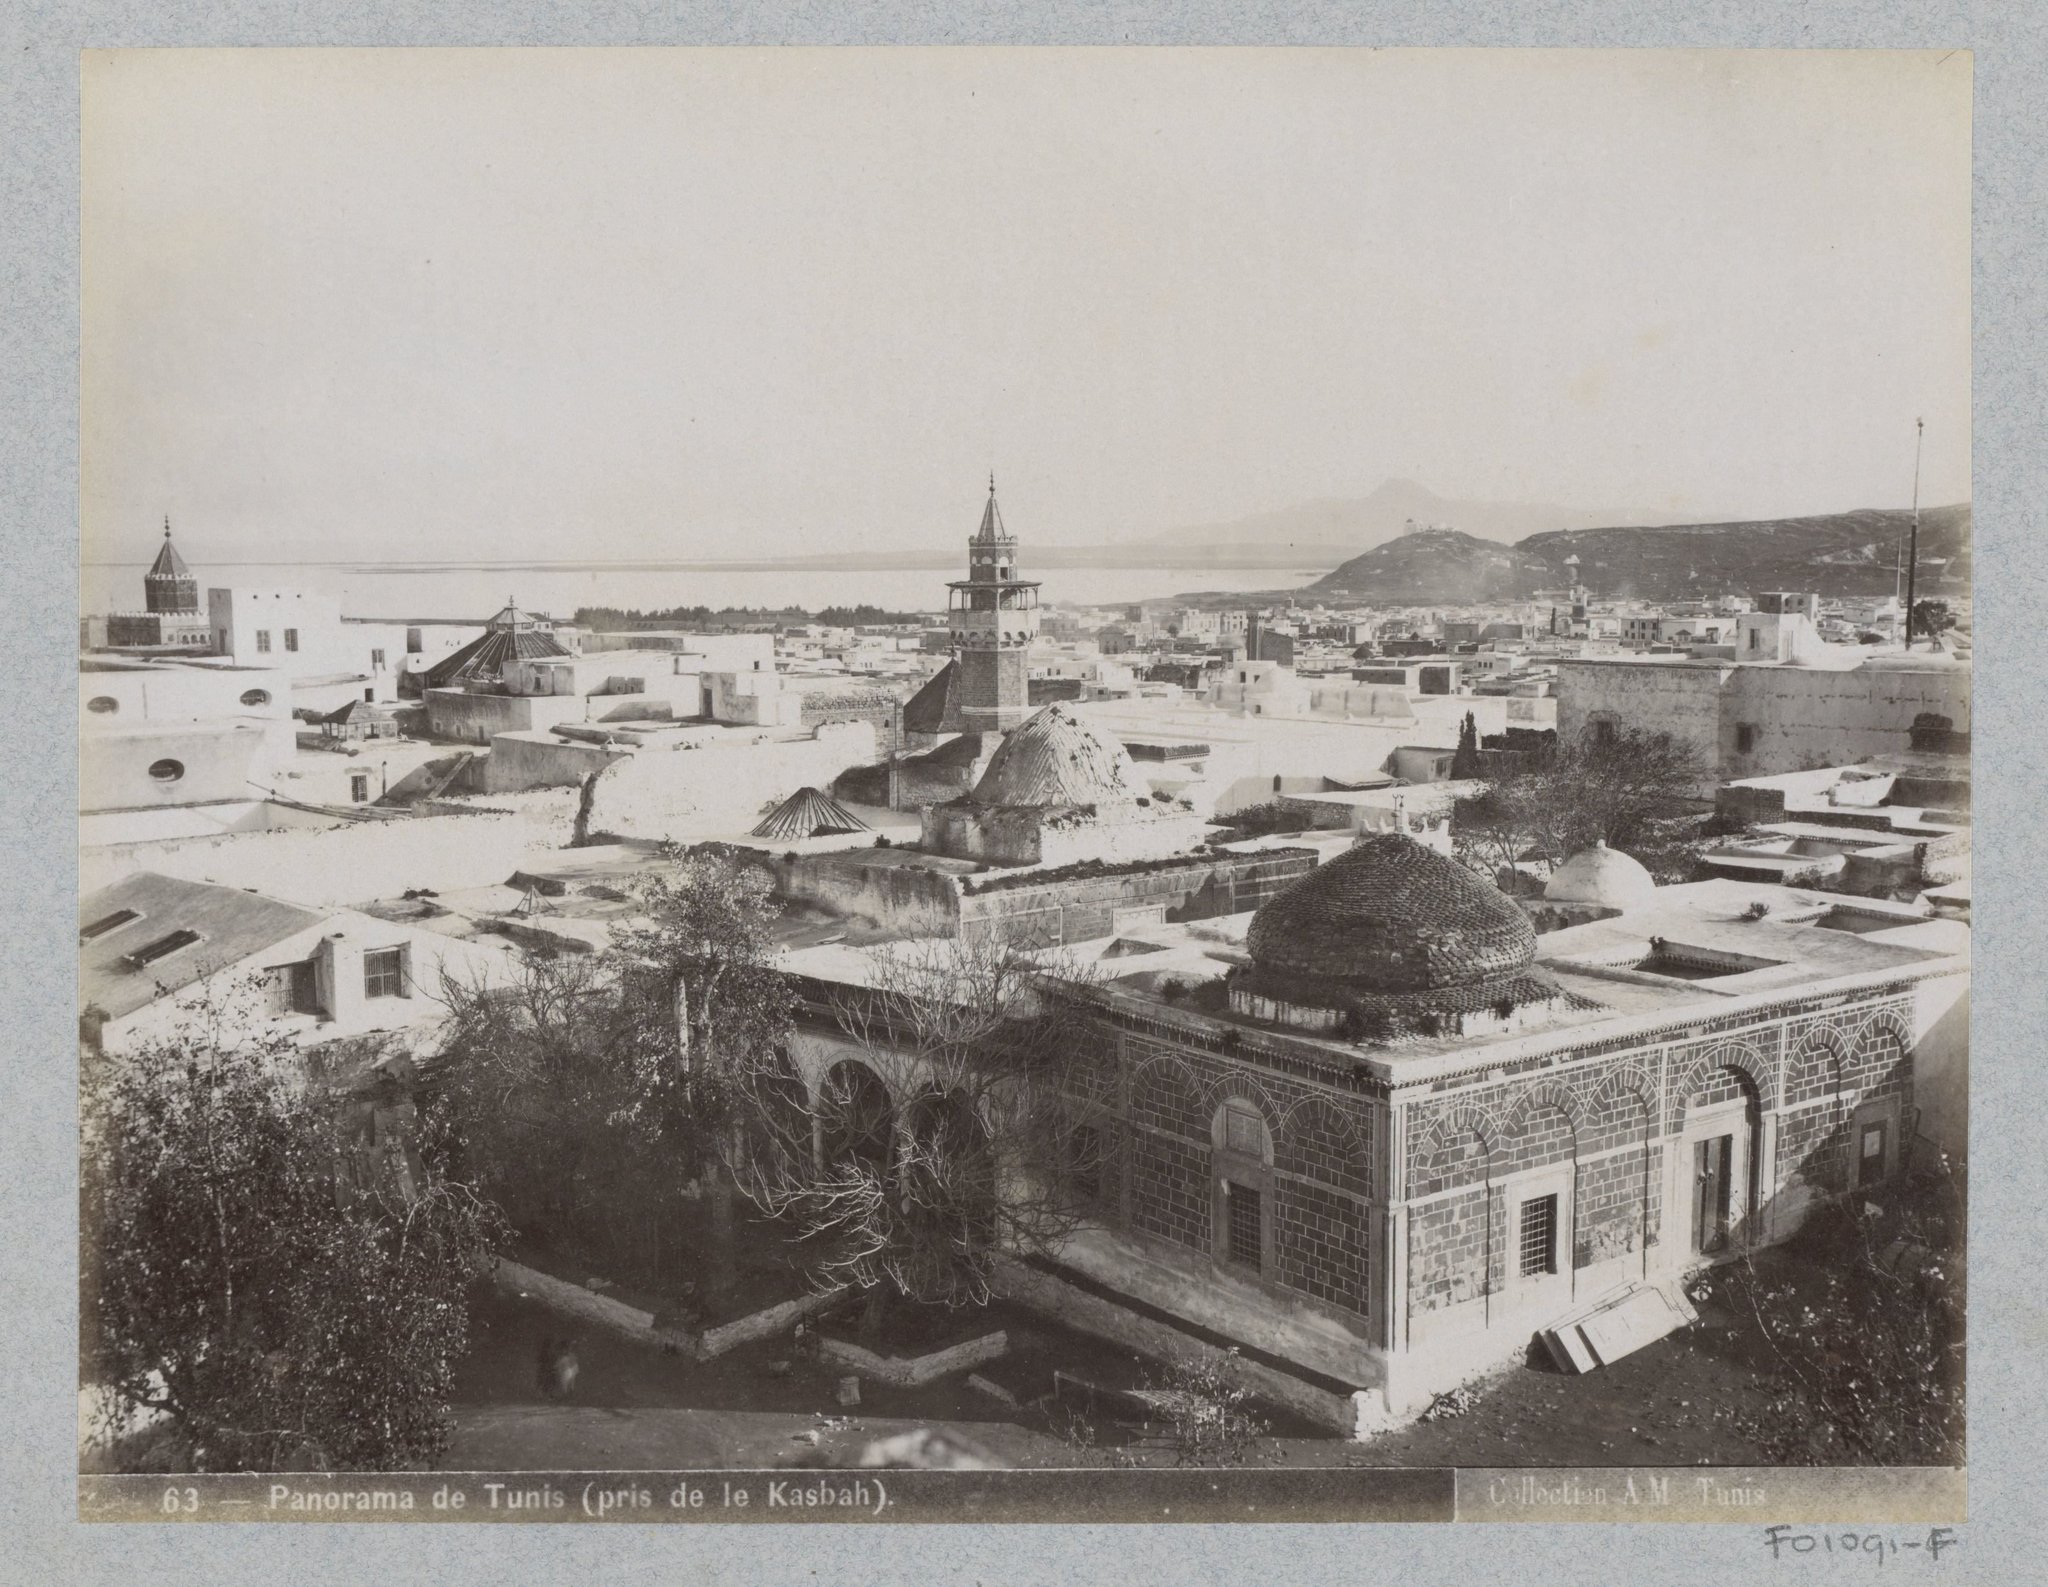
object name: album leaf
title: Gezicht op Tunis vanuit de kasba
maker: am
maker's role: fotograaf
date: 1880-1900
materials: paper, photographic support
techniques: albumen print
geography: tunis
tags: temple, shrine ~ islam, mohammedanism, prospect of city, town panorama, silhouette of city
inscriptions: negative number: ‘63’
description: Onderdeel van Reisalbum met foto's van bezienswaardigheden in Tunis en Tunesië.